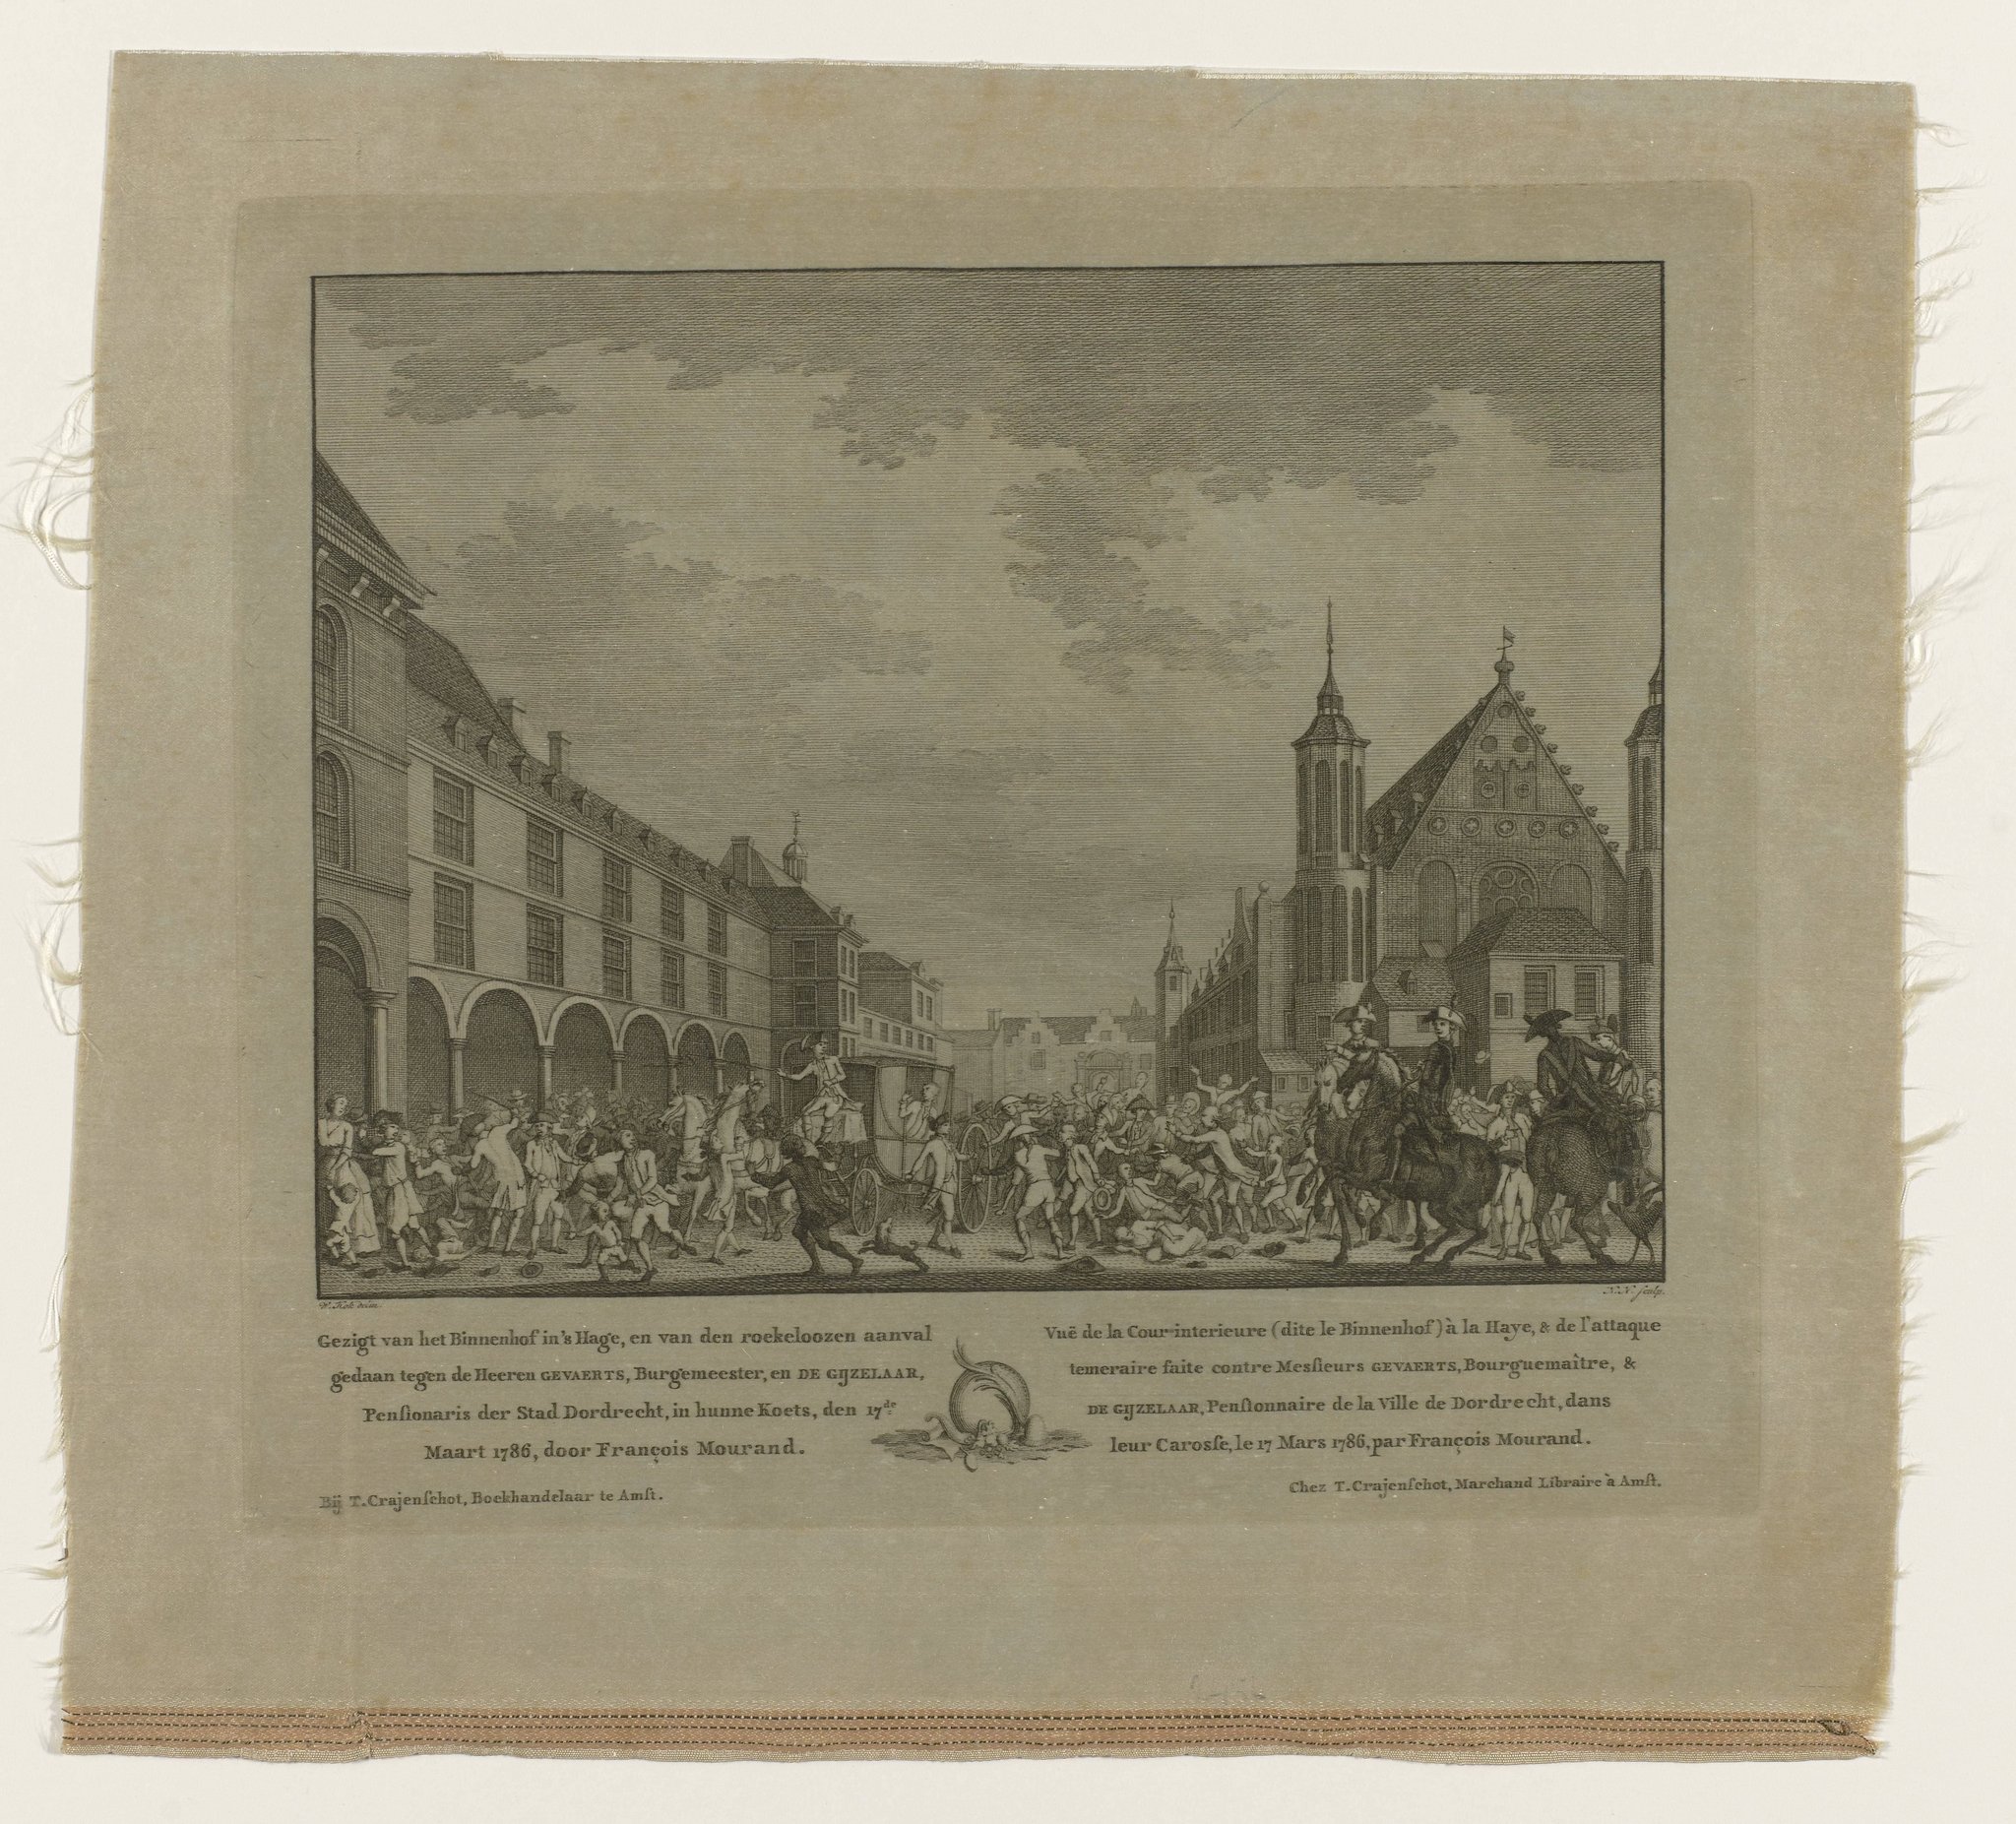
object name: print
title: Gezigt van het Binnenhof in 's Hage, en van de roekeloozen aanval gedaan (...) / Vuë de la Cour interieure (dite le Binnenhof) à la Haye, & de l'attaque temaire faite (...)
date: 1786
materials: silk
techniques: etching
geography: amsterdam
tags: revolutionary action (violent)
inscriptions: collector's mark: Lugt 2228, collector's mark: Lugt 2760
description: Ongeregeldheden als de gedeputeerden van Dordrecht, de heren Gevaerts en De Gijzelaar, met hun rijtuig door de Stadhouderspoort het Binnenhof op rijden en hun paarden bij de toom worden gegrepen door de Haagse pruikenmaker F. Mourand, 17 maart 1786. In het onderschrift een vignetje en de titels in het Nederlands en Frans.